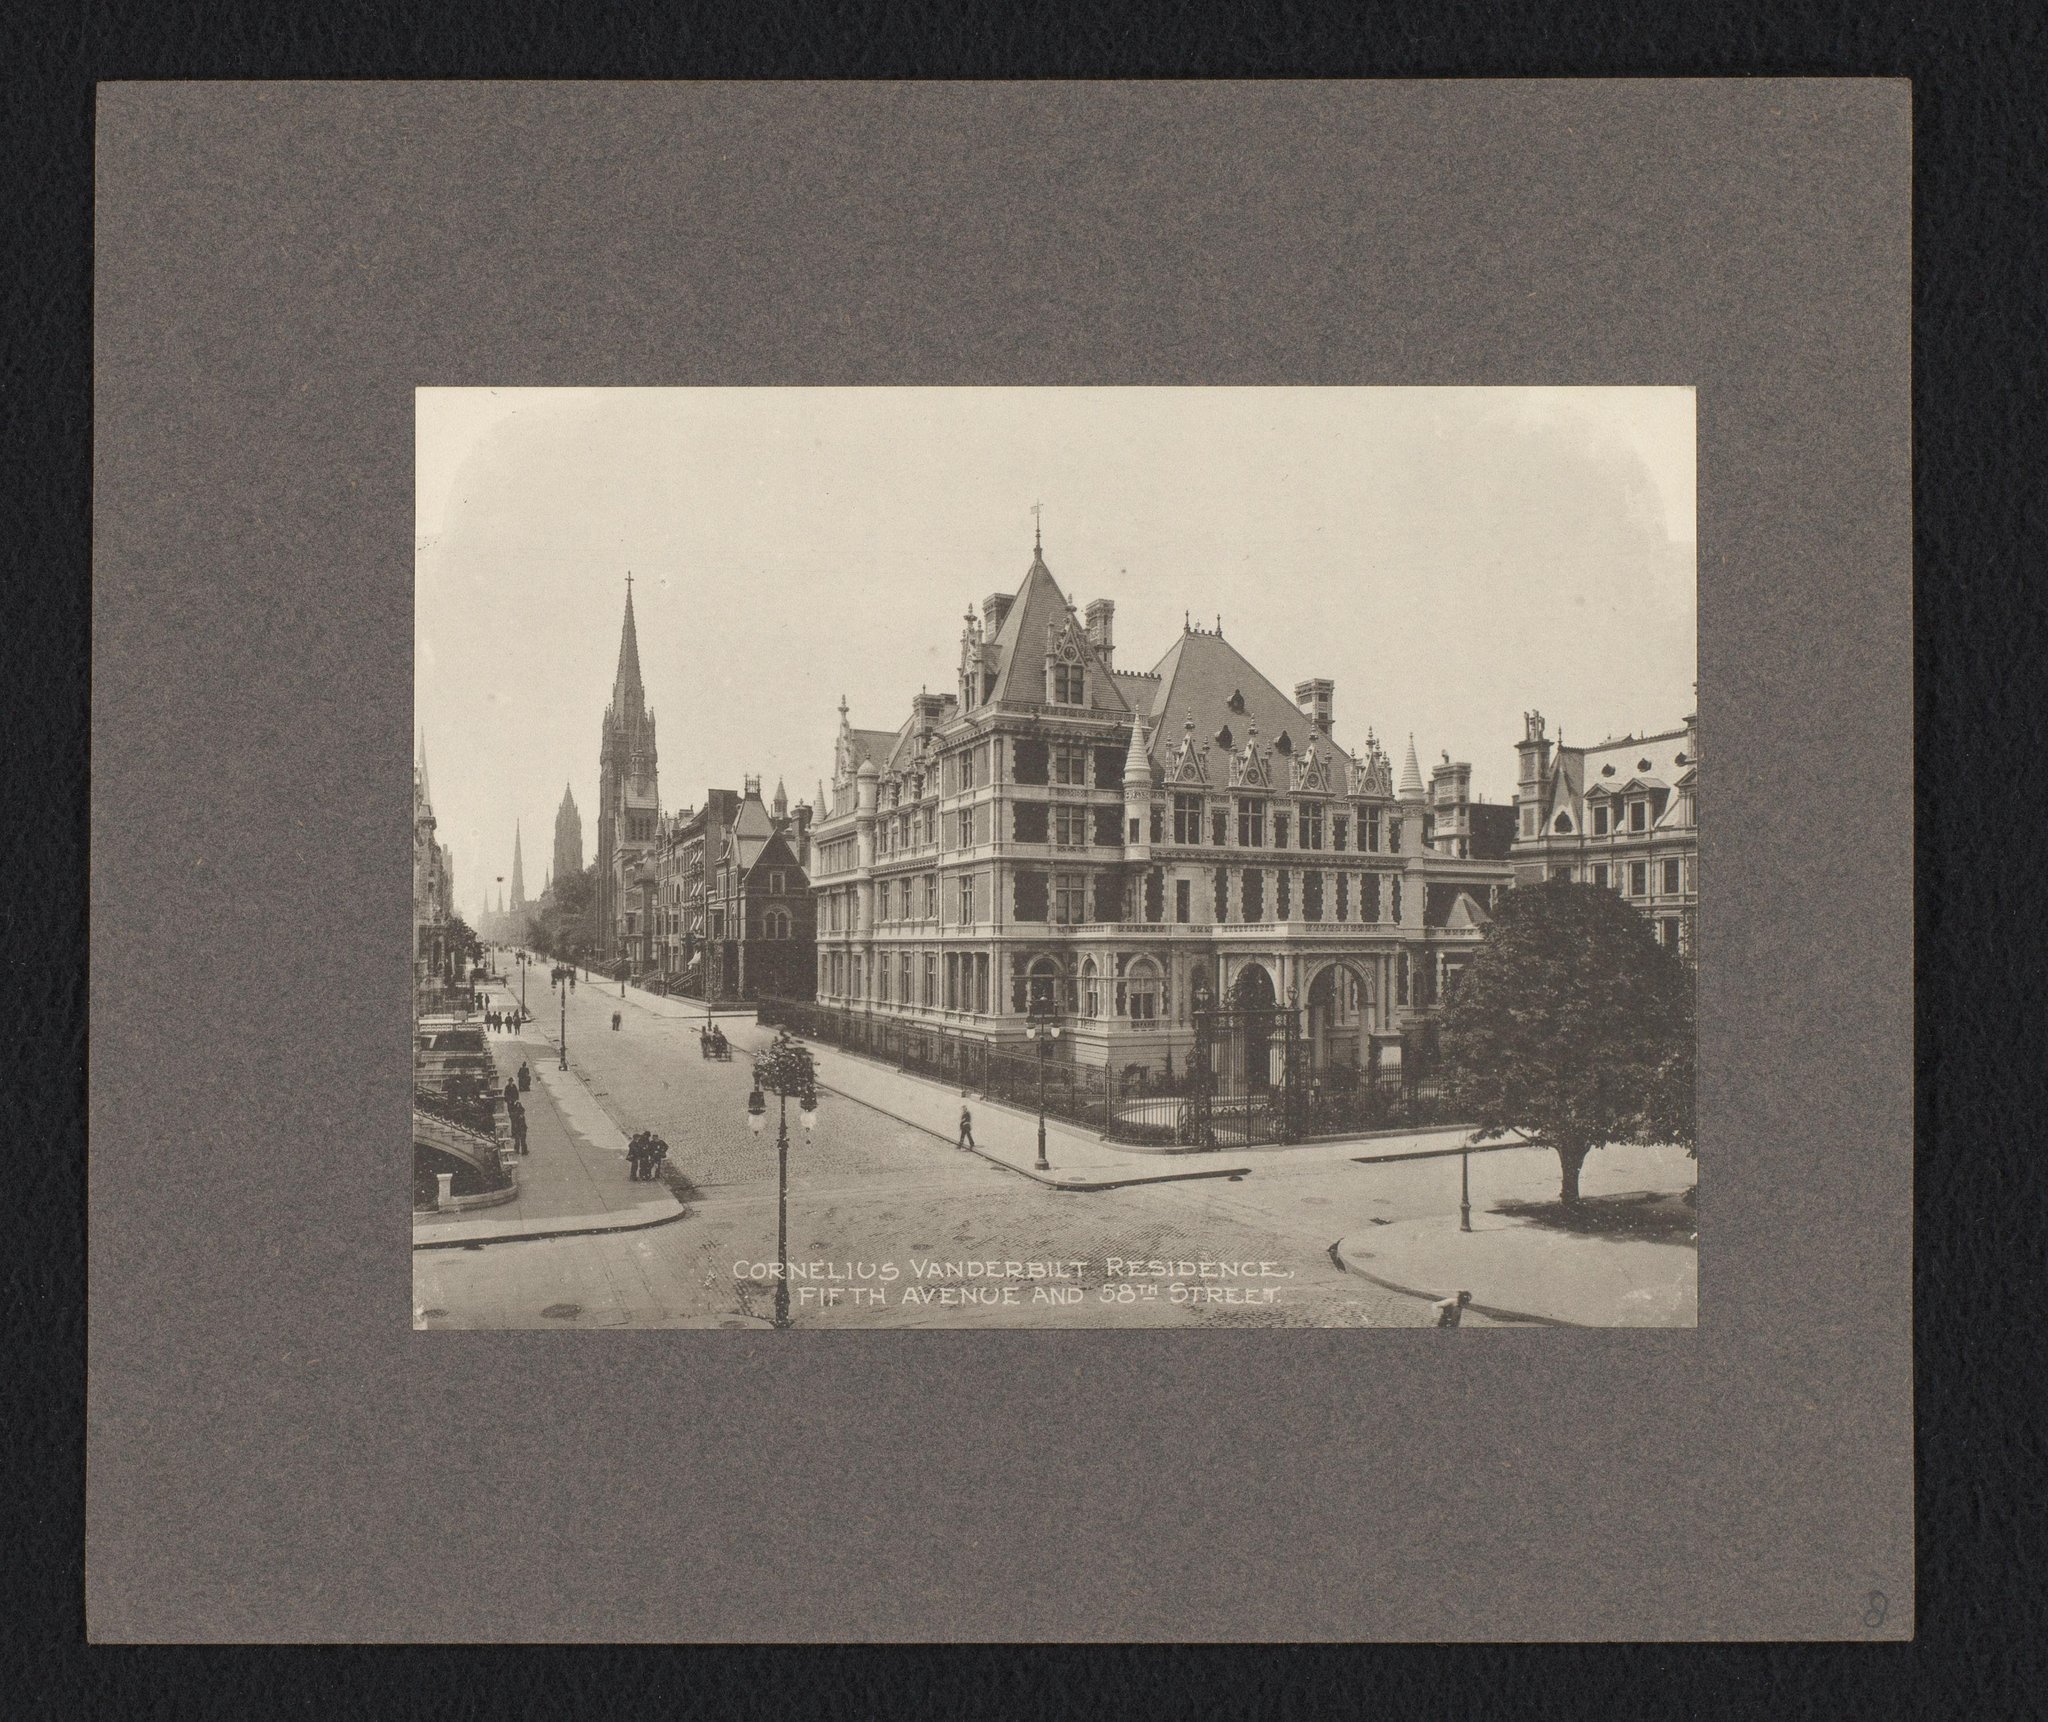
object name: photomechanical print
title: Gezicht op het Cornelius Vanderbilt II House, New York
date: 1902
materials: paper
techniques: photograph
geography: new york city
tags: exterior ~ representation of a building, street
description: Deze prent maakt deel uit van een album.